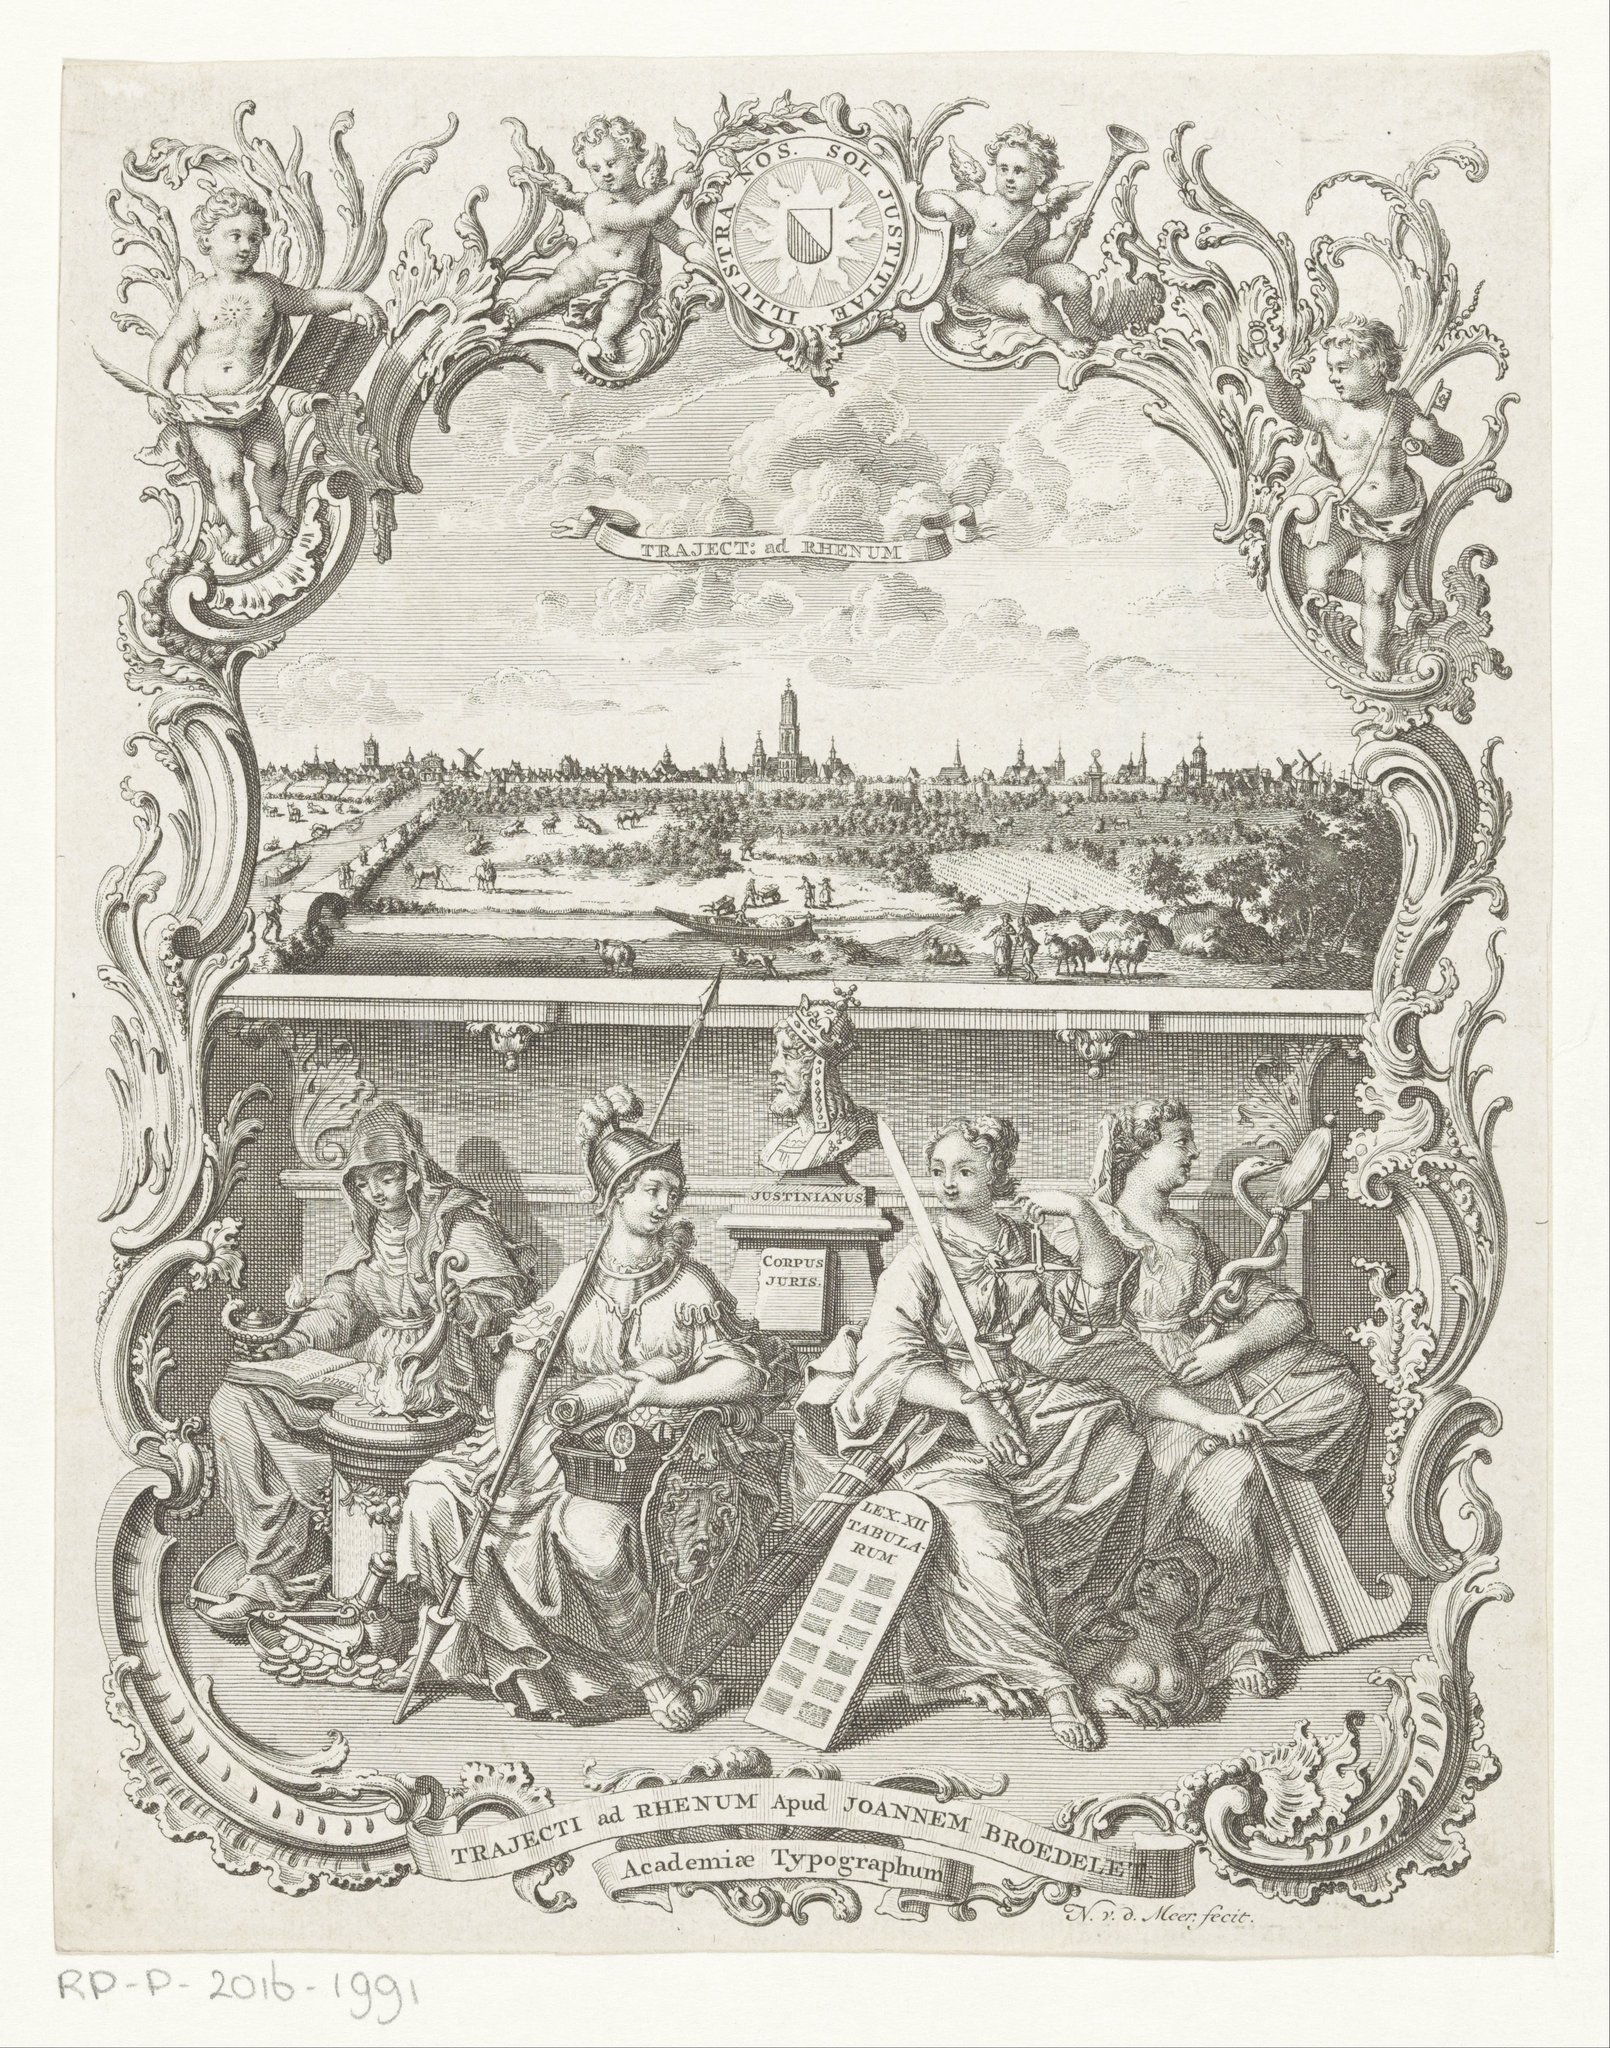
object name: print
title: Gezicht op Utrecht en allegorie met Minerva en deugden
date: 1728-1771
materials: paper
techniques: etching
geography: utrecht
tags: temperance, 'temperantia'; 'temperanza' (ripa) ~ one of the four cardinal virtues, justice, 'justitia'; 'giustitia divina' (ripa) ~ one of the four cardinal virtues, prudence, 'prudentia'; 'prudenza' (ripa) ~ one of the four cardinal virtues, (story of) minerva (pallas, athena), utrecht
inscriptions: collector's mark: Lugt 2228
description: Een gezicht op de stad Utrecht met het silhouet van de Domkerk in een architecturale omlijsting met Minerva en drie personificaties van deugden: Matigheid, Rechtvaardigheid en Voorzichtigheid. De lijst wordt bekroond met een rond schild met het motto van de universiteit van Utrecht tussen twee putti die op bazuinen blazen.